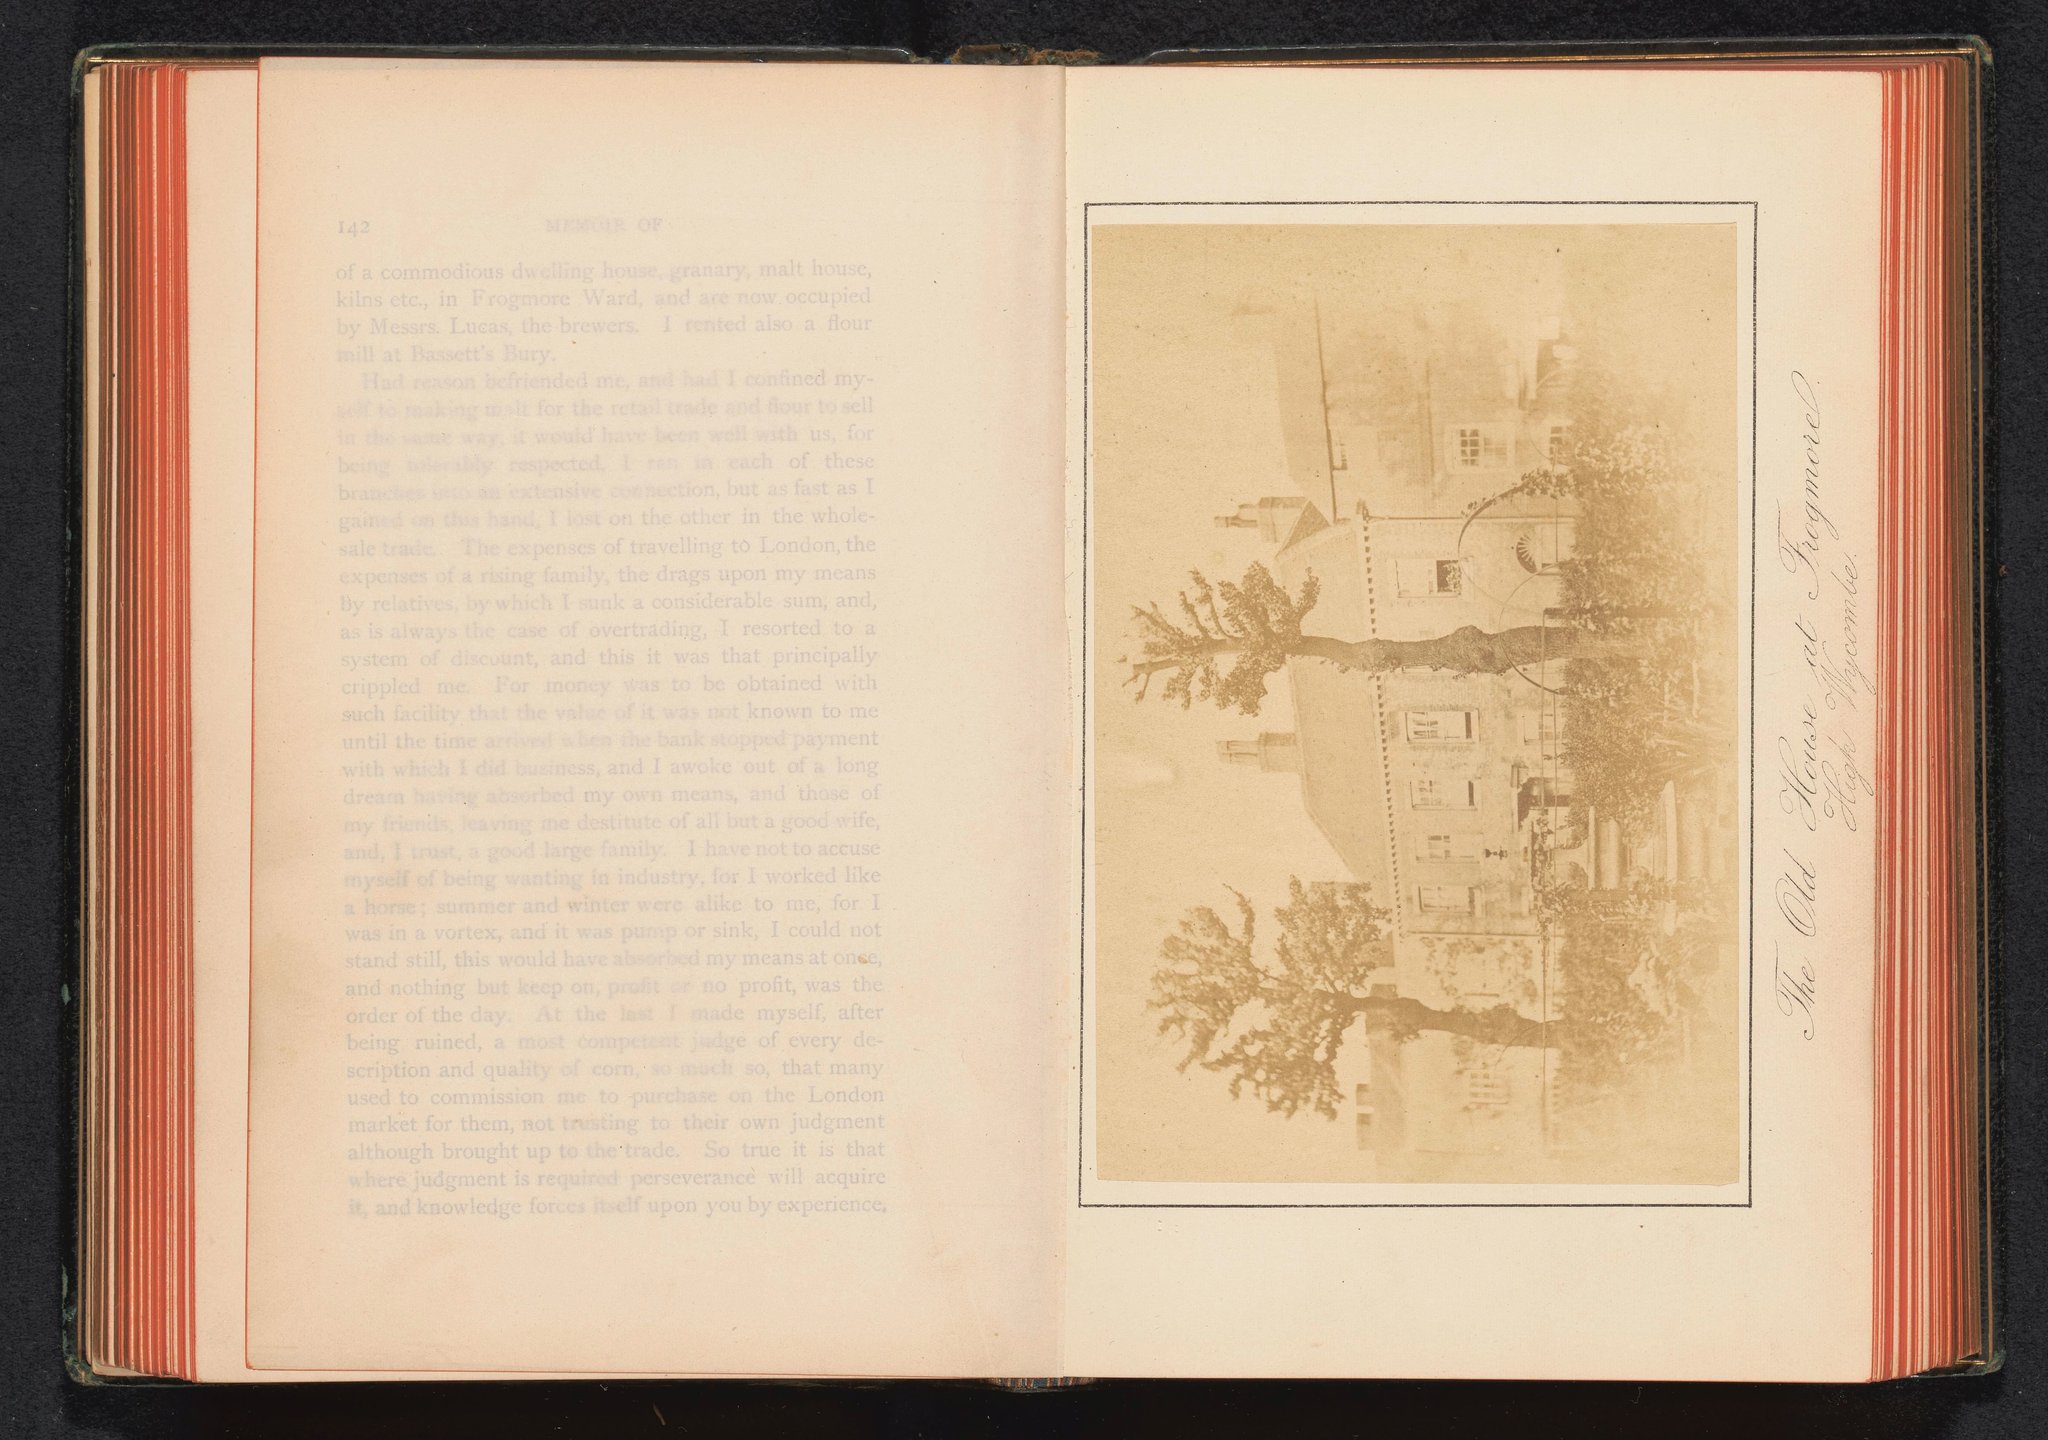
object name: photograph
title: The old house at Frogmore. High Wycombe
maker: j. perry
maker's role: fotograaf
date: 1872-1882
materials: photographic support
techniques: albumen print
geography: high wycombe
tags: housing, façade (of house or building)